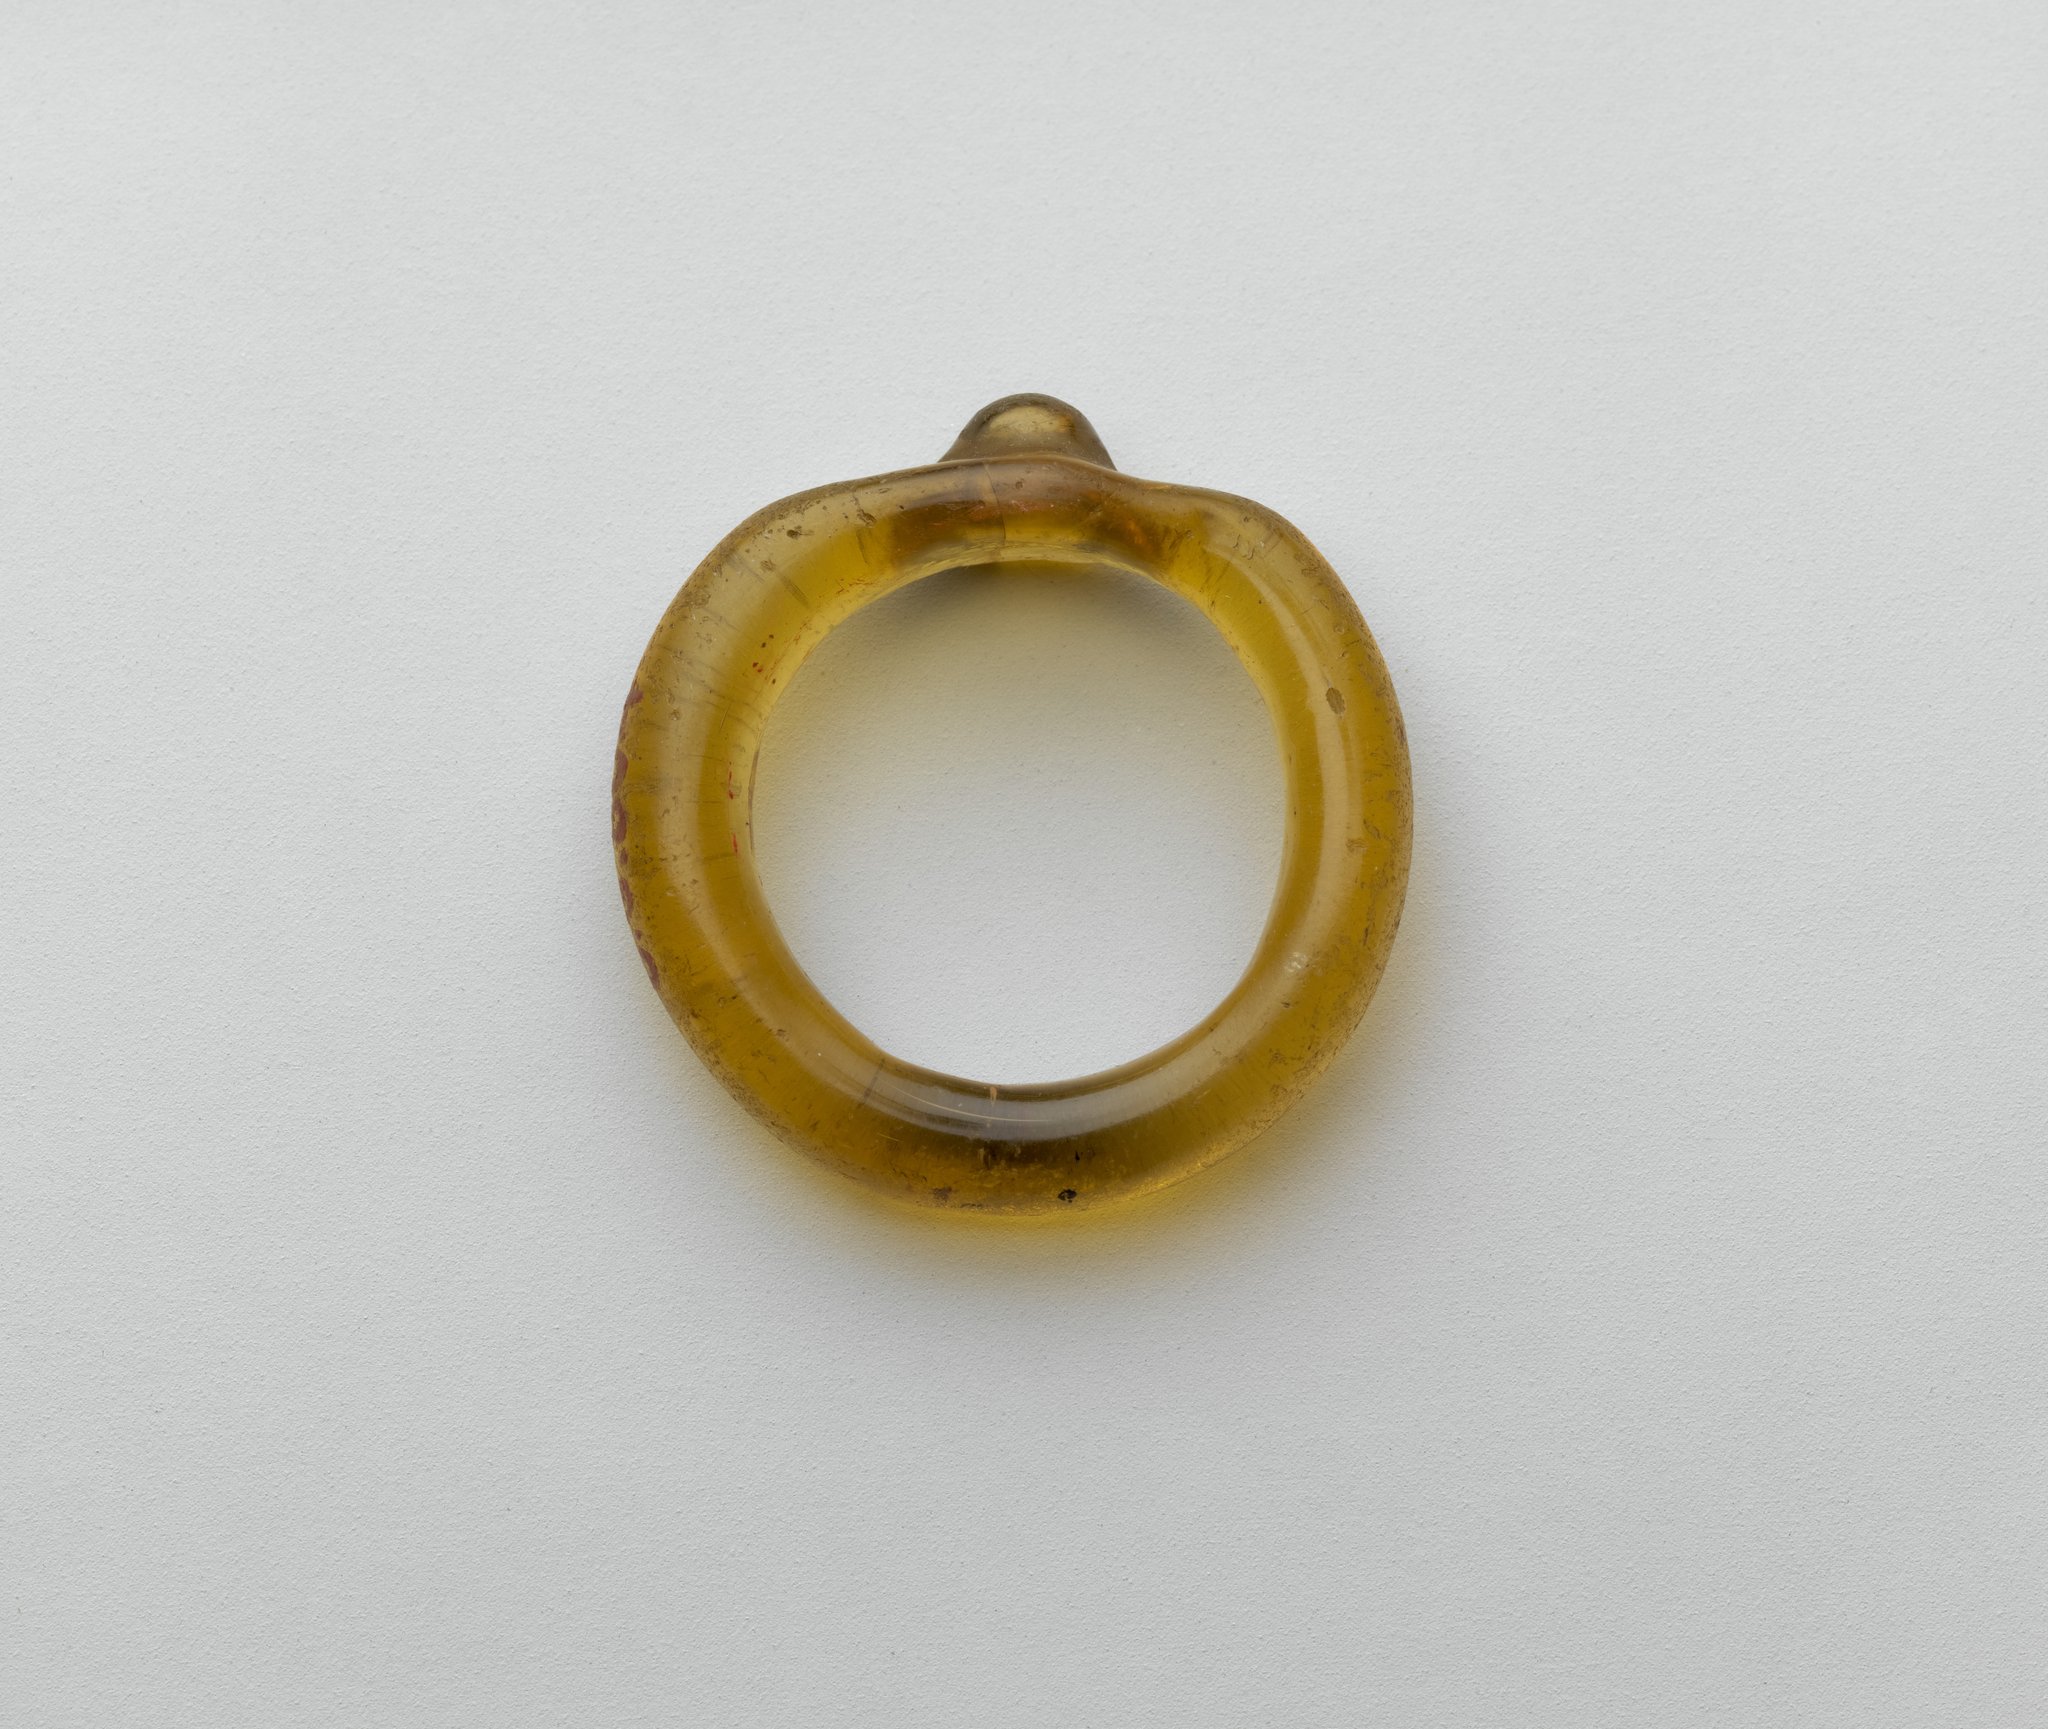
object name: ring with knobbed bezel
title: Glass ring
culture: roman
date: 101-200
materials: amber, glass